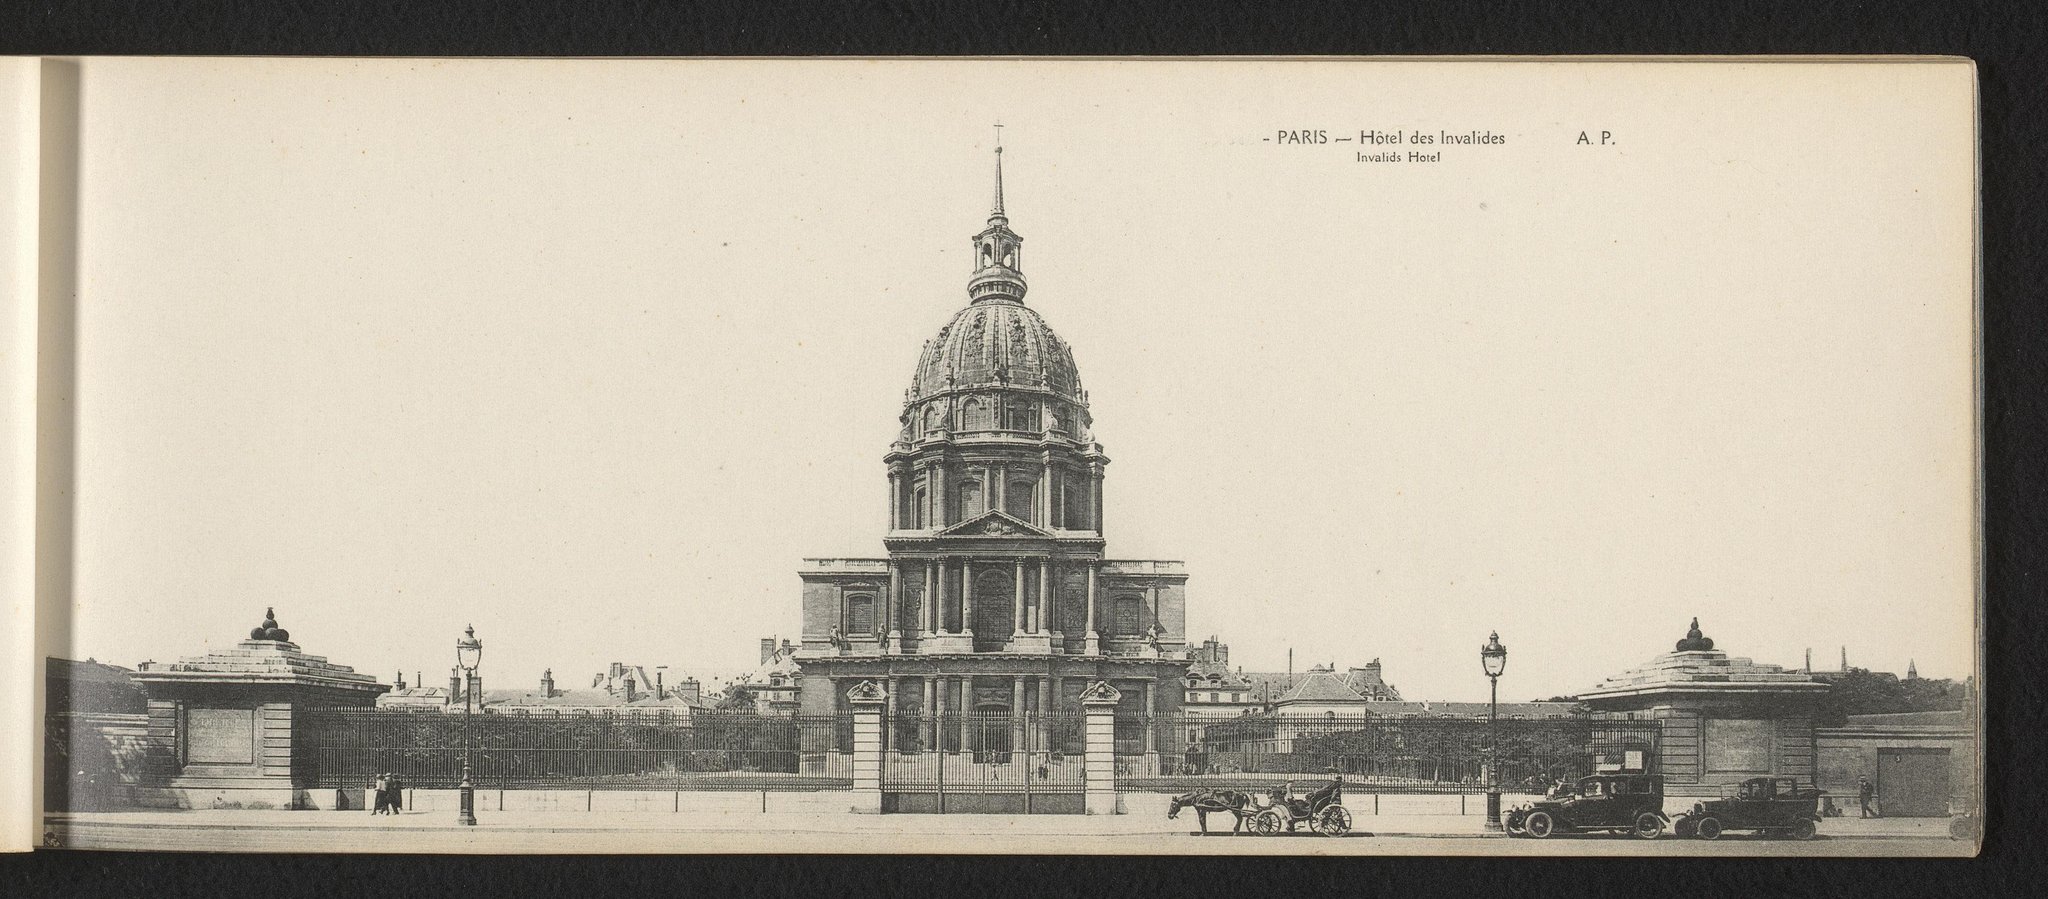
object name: photomechanical print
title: Paris. Hôtel des Invalides / Invalids Hotel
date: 1910-1925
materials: cardboard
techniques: photograph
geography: paris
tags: hospital, dome ~ architecture